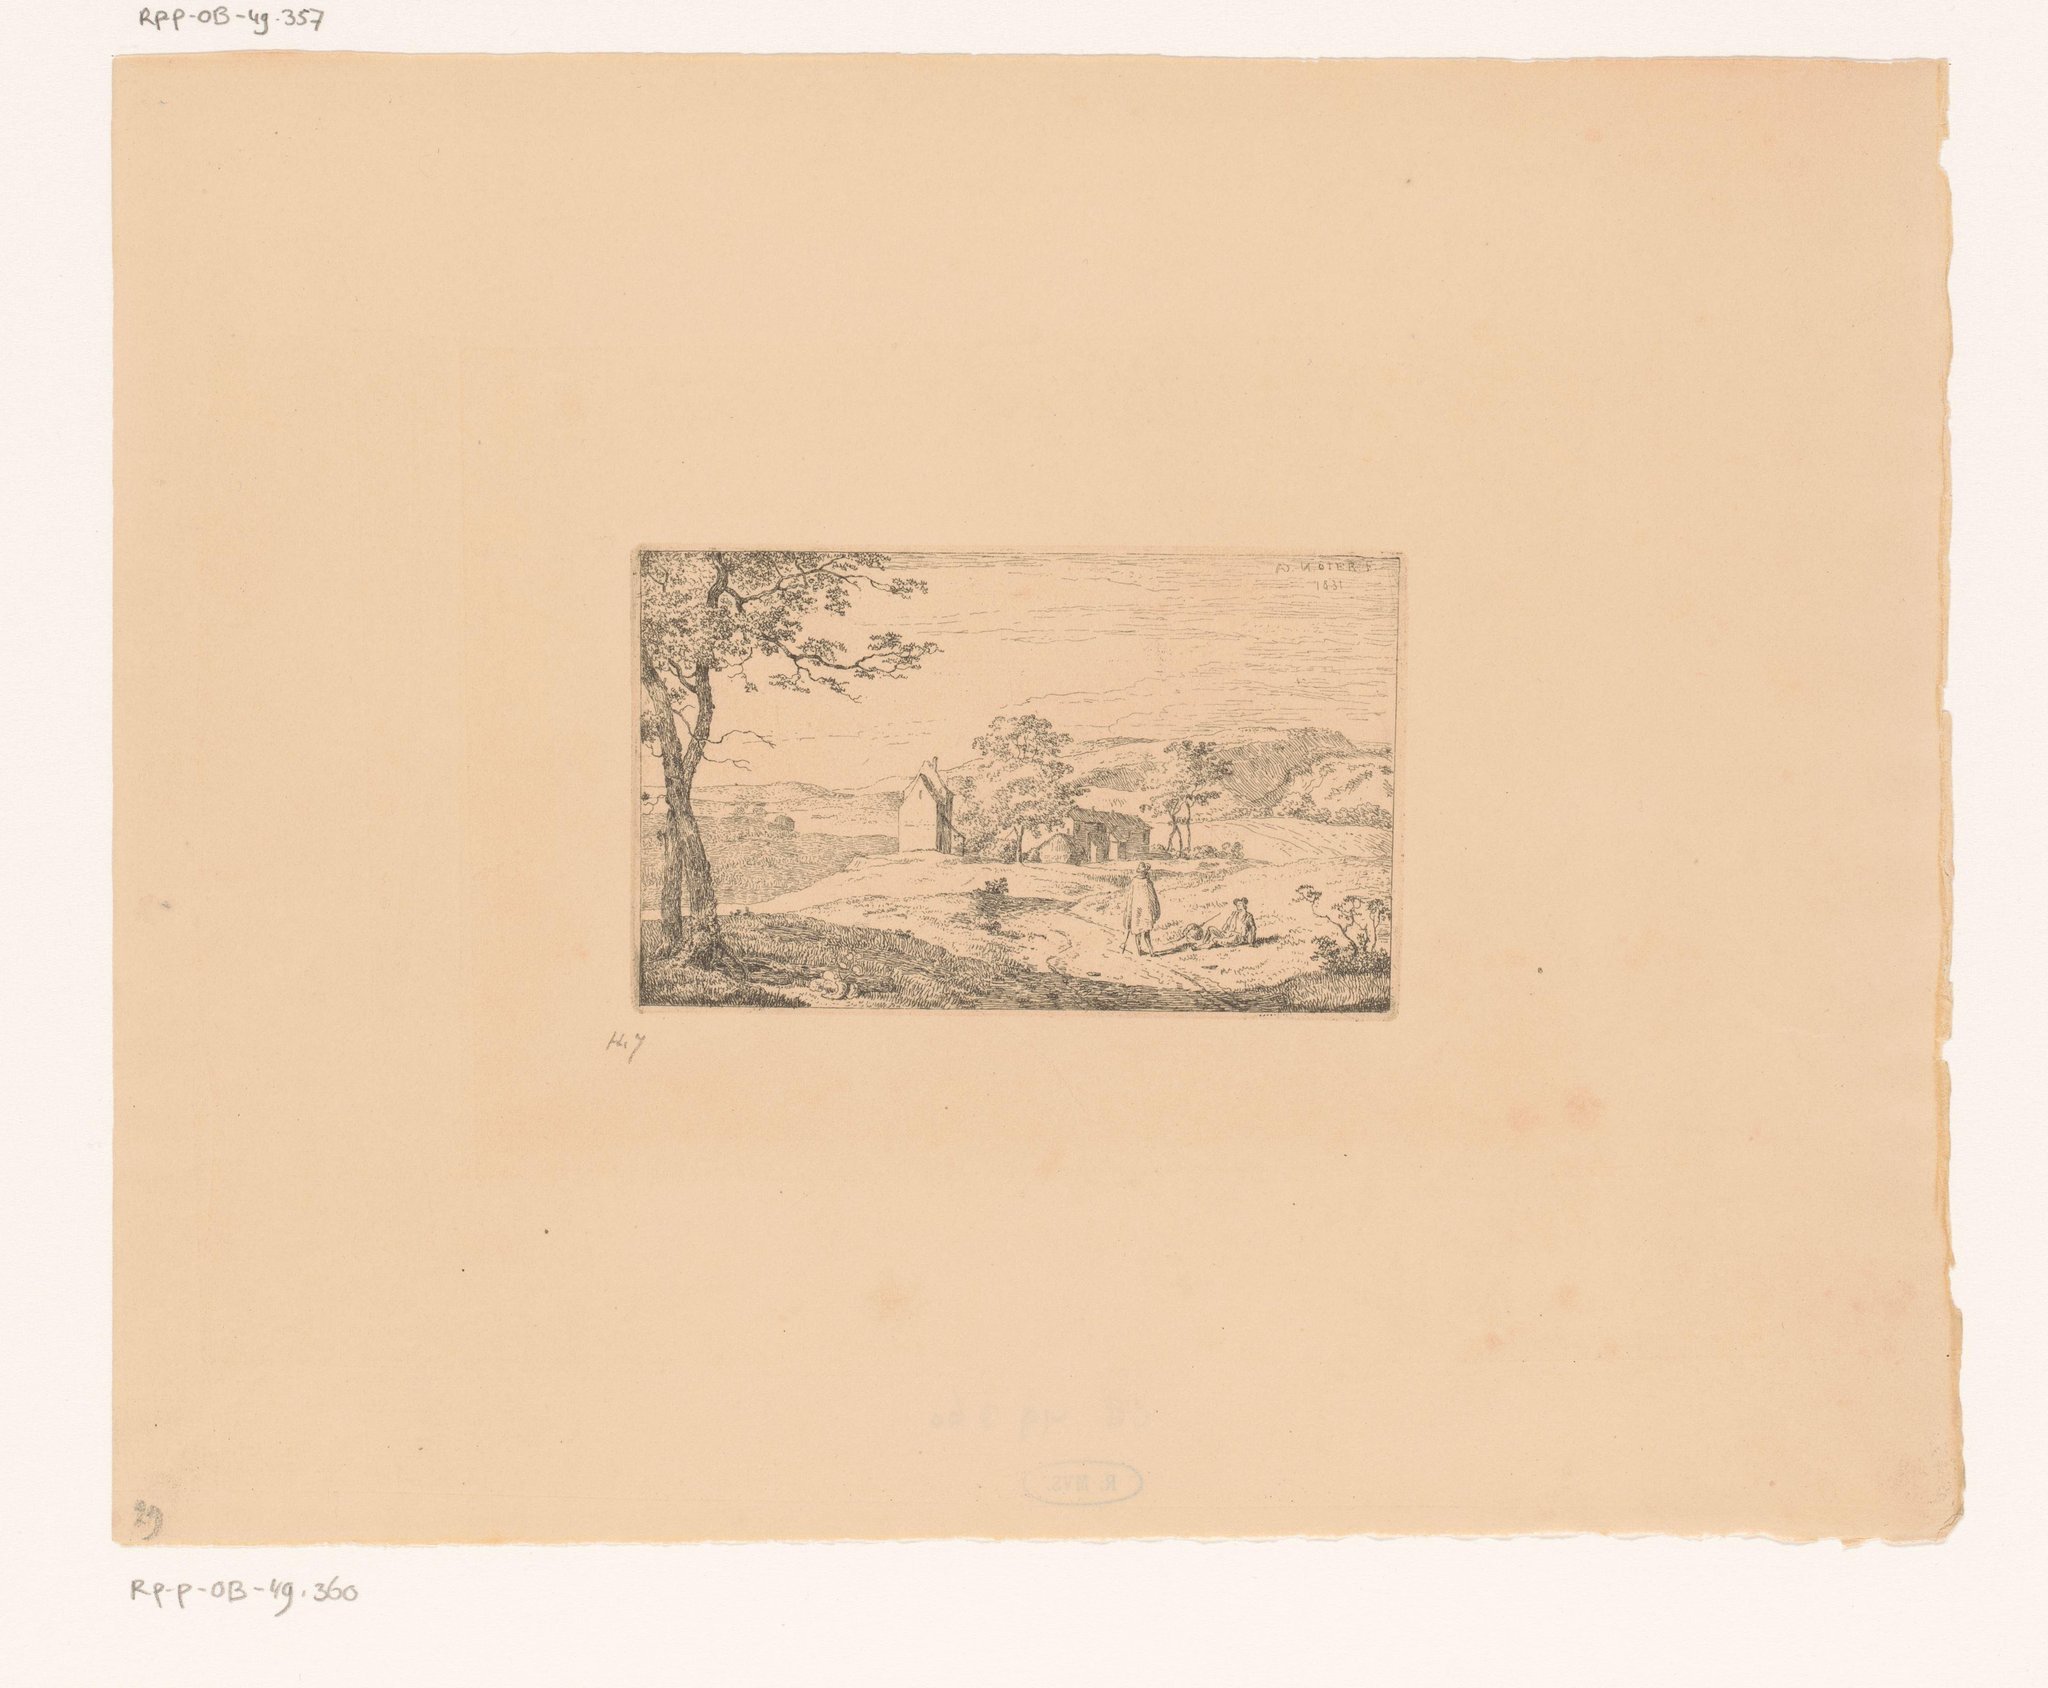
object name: print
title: Landschap met wandelaars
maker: auguste herman marie de noter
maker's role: print maker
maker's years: 1806-1838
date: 1831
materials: paper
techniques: etching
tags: landscapes (+ landscape with figures, staffage), farm or solitary house in landscape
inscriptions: collector's mark: Lugt 2228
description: Eén van de wandelaars rust uit in het gras.